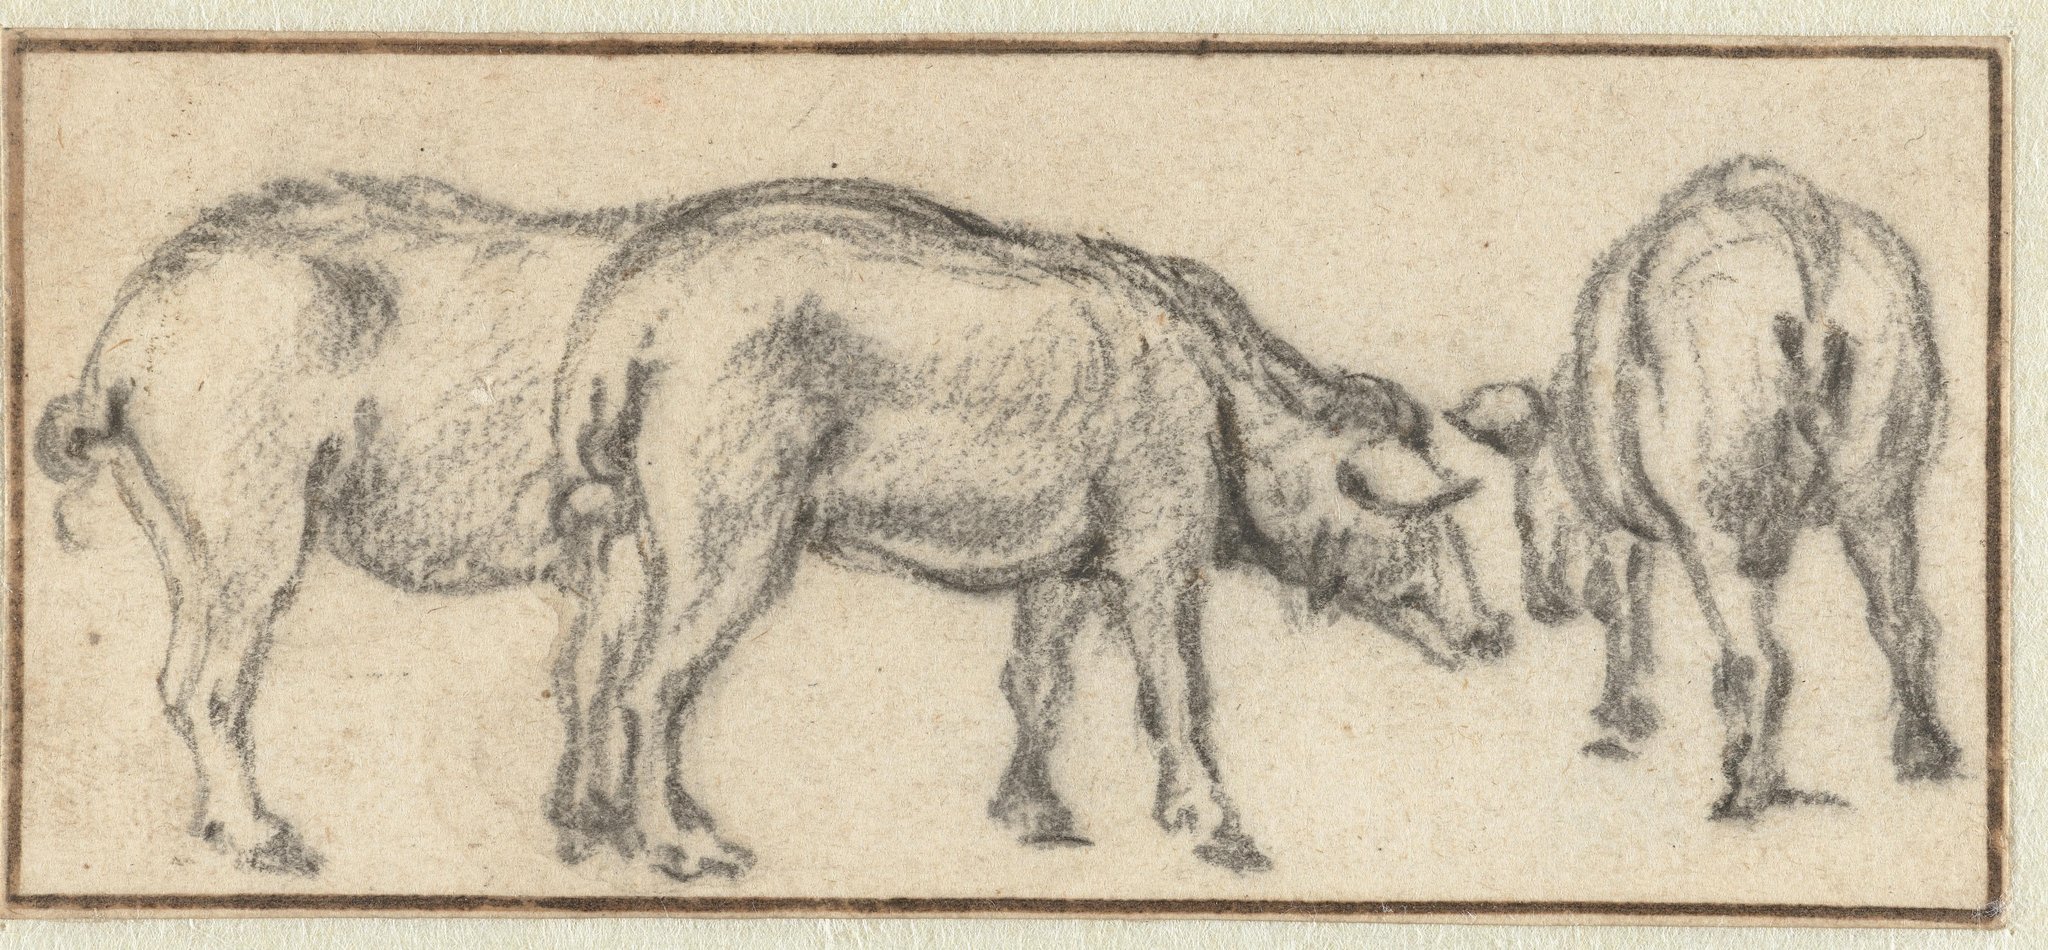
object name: drawing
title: Drie varkens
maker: karel du jardin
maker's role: draughtsman, painter, print maker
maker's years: 1626-1678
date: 1632-1678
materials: chalk, paper